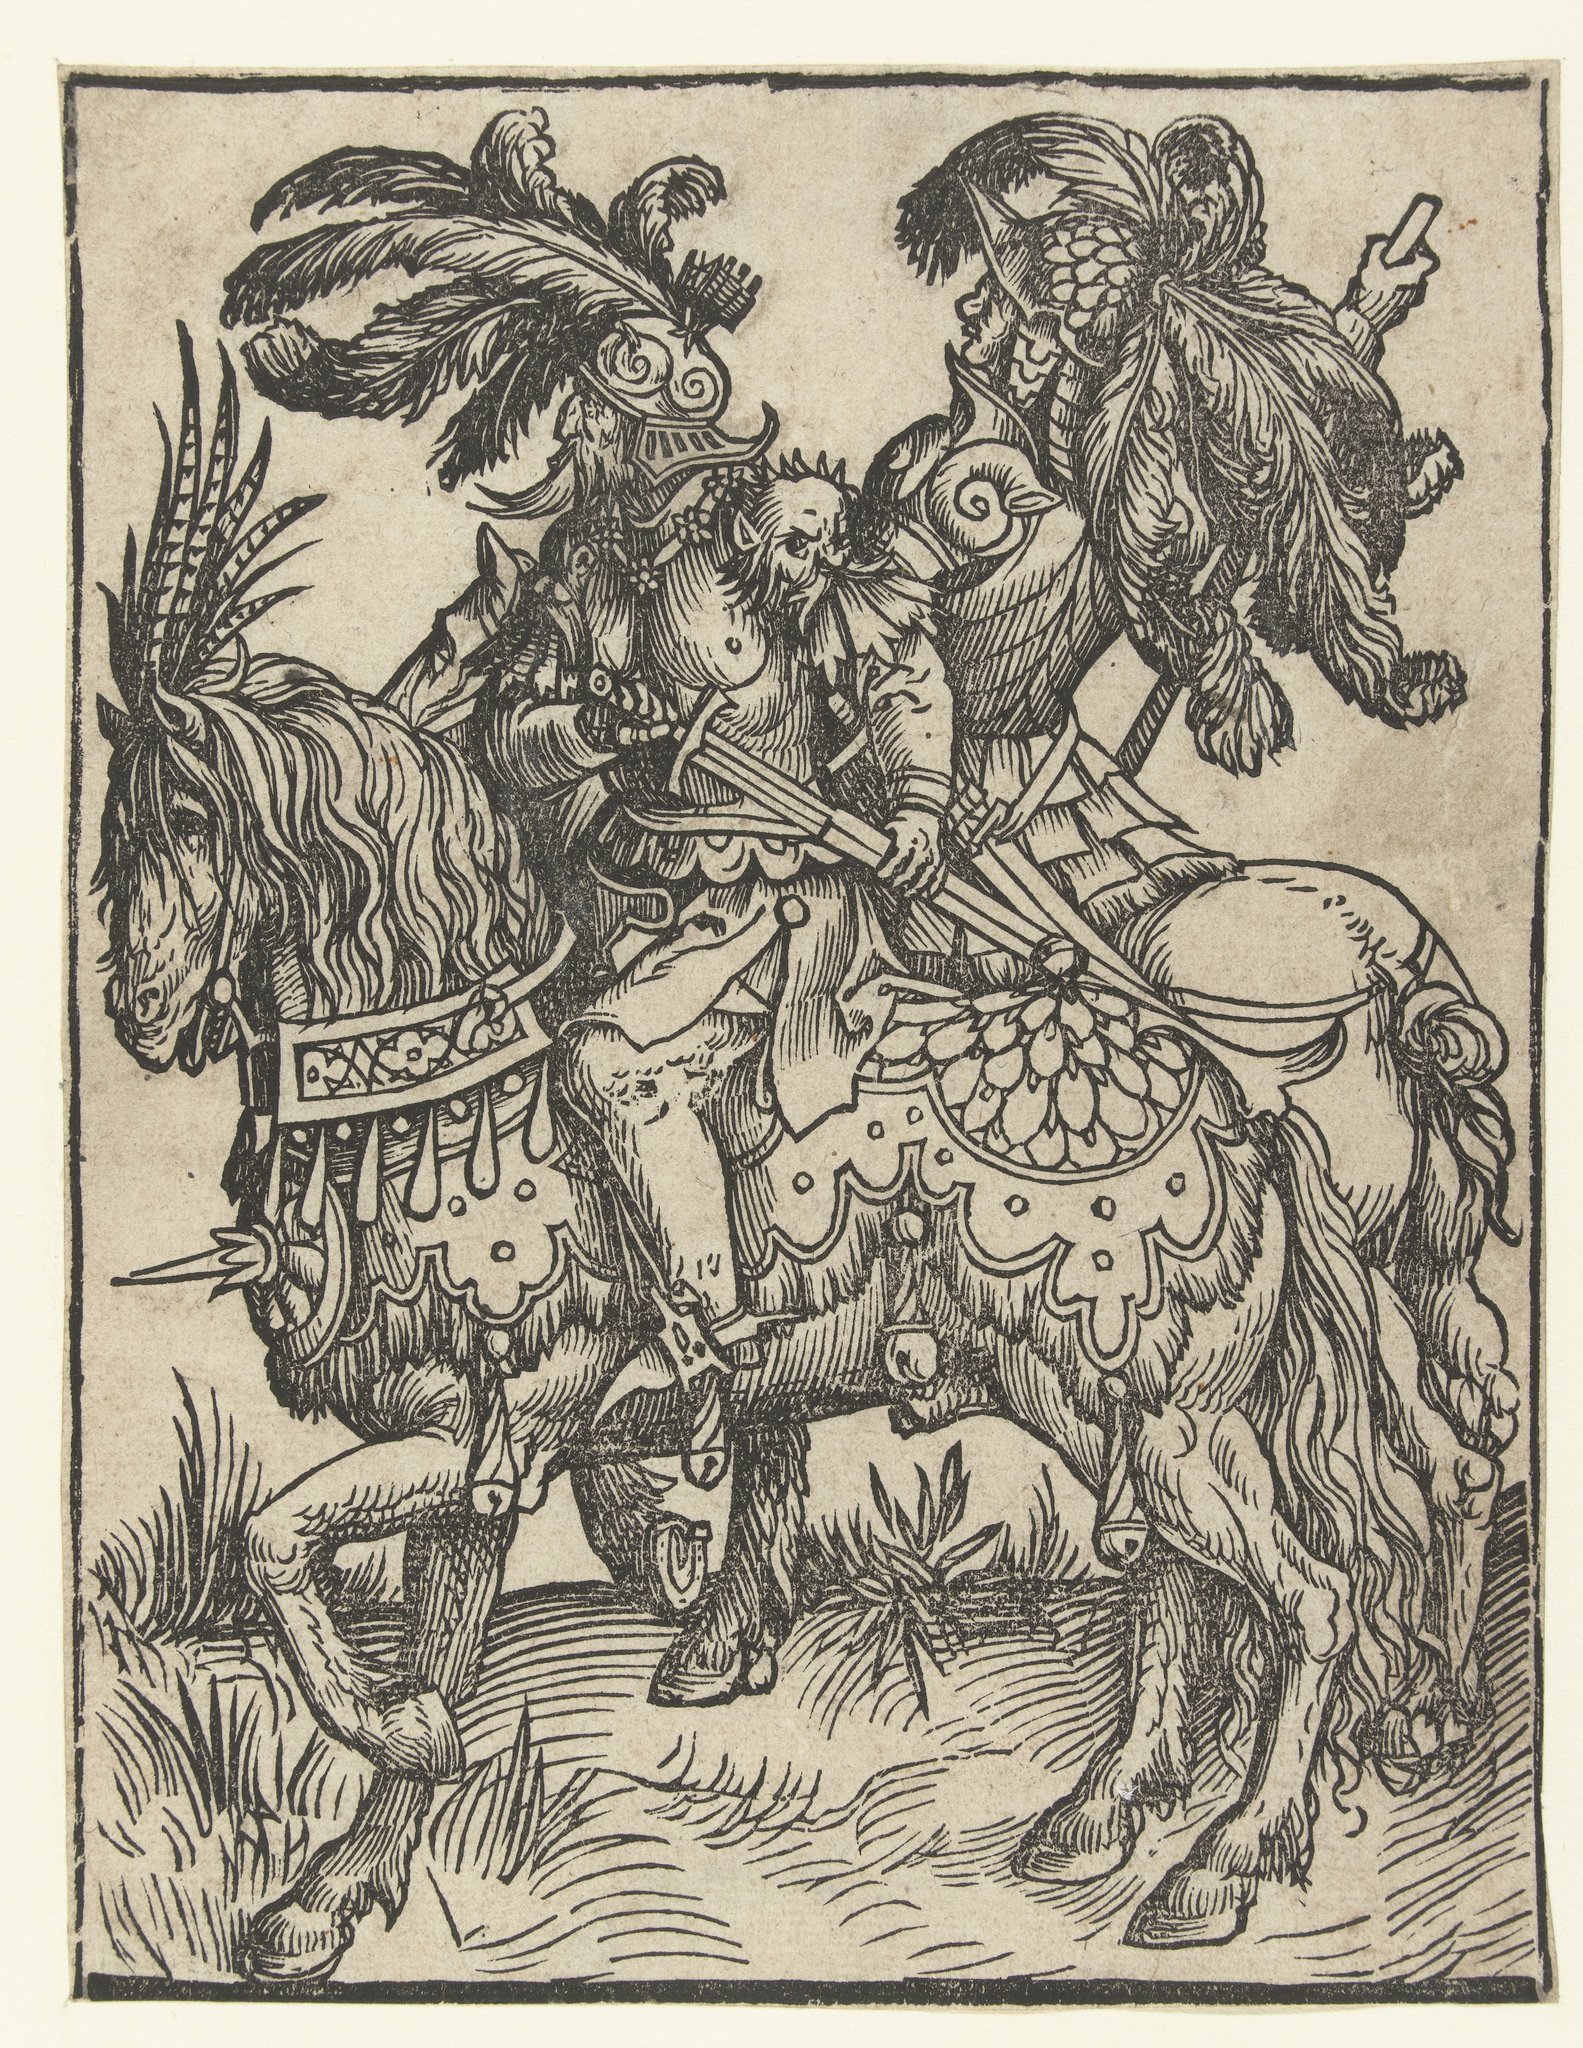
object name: print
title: De Graven en Gravinnen van Holland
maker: jacob cornelisz van oostsanen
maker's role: draughtsman, painter, print maker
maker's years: 1475-1533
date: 1518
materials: paper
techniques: woodcut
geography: low countries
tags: earl, equestrian state-portrait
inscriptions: collector's mark: Lugt 240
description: Twee uitgaven van de serie zijn bekend: één met Franse teksten en een titelblad met de naam van de uitgever Doen Pietersz. in Amsterdam en de dagtekening 1.4.1518, en één met Latijnse teksten, waarvan het titelblad ontbreekt, op het laatste blad opgedragen aan Karel V. Fragmenten van de later versneden blokken werden opgenomen in de "Cronicke van Brabant", Antwerpen 1530, door Jan van Doesborch.